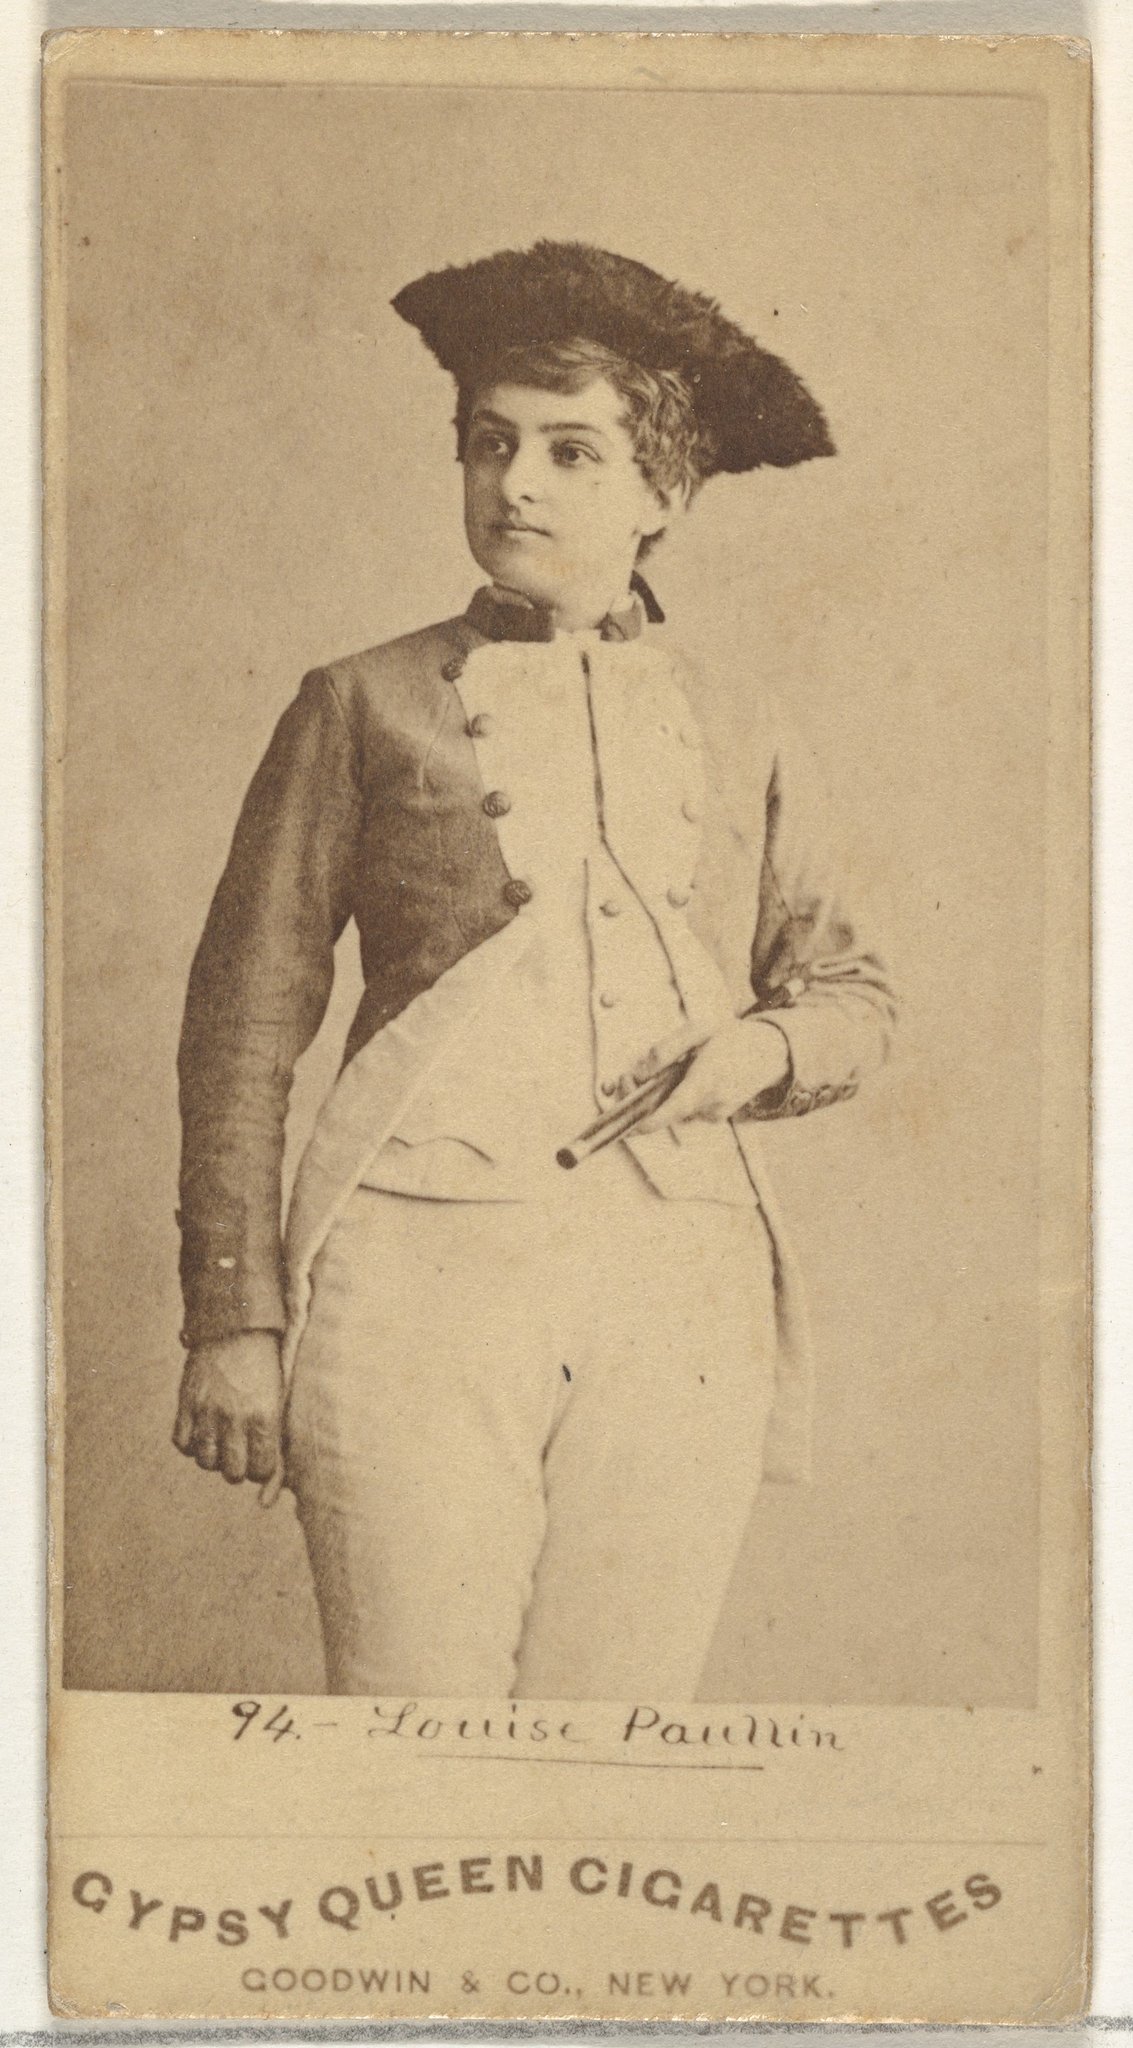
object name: photograph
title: Louise Paullin, from the Actors and Actresses series (N171) for Gypsy Queen Cigarettes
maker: goodwin & company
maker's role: publisher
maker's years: 1850-1950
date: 1886-1890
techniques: albumen silver print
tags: portraits,women,actresses